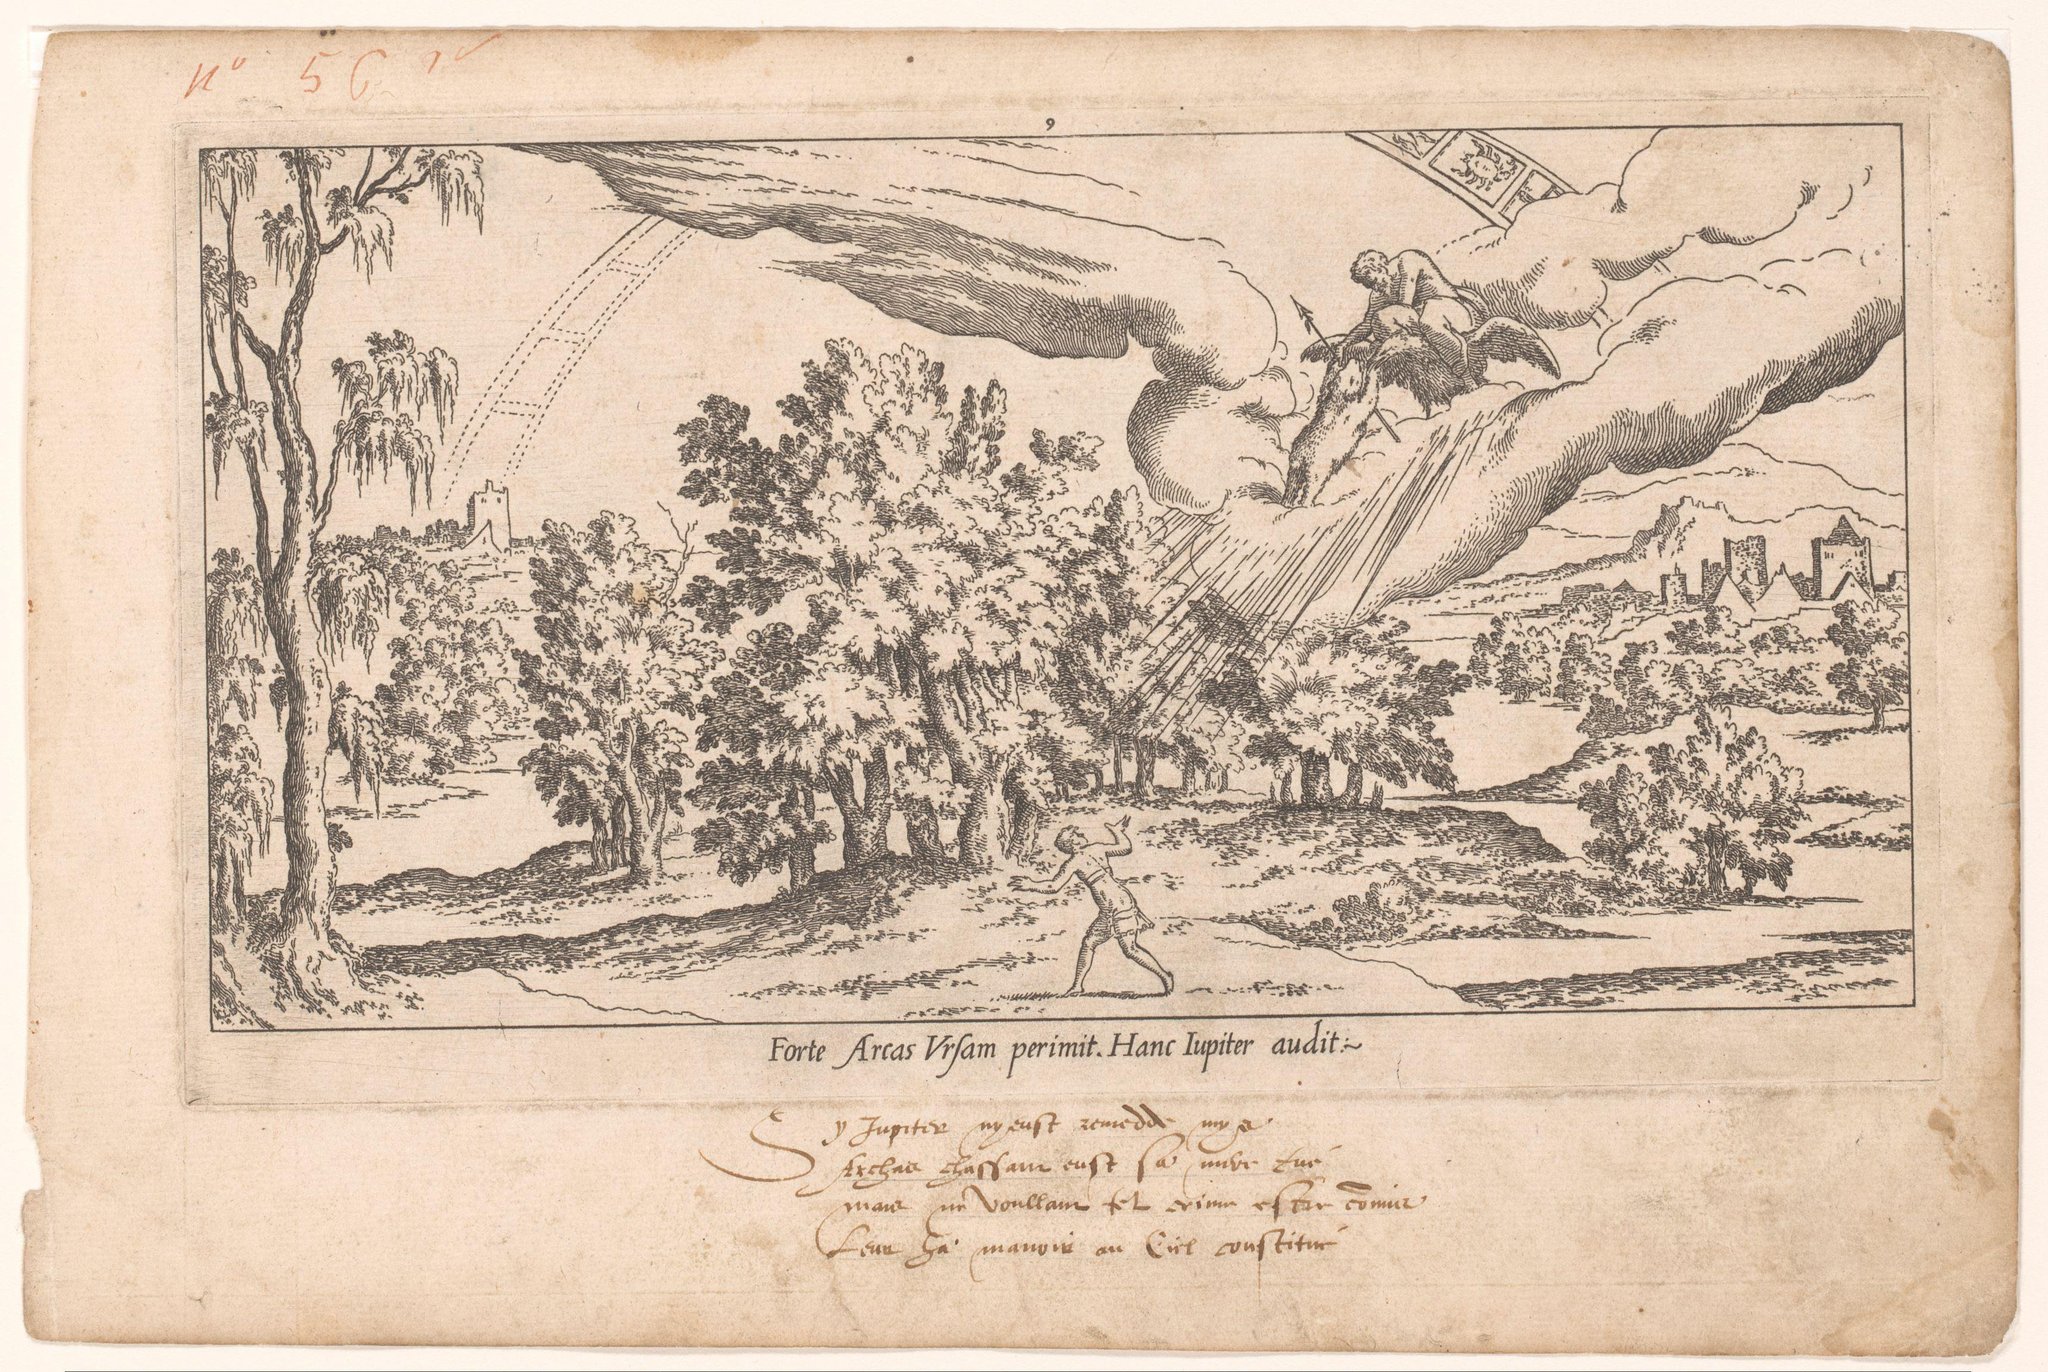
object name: print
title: Callisto wordt door Jupiter opgenomen in de sterrenhemel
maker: léon davent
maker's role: print maker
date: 1547-1550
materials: paper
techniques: etching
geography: france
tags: callisto changed into a constellation: jupiter changes callisto into a constellation, when, transformed into a bear she is about to be shot by arcas (ovid, metamorphoses ii 506)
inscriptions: collector's mark: Lugt 2760, inscription:, number:, collector's mark: Lugt 2228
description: Bosrijk landschap waarbij Callisto net niet gedood wordt door haar zoon Arcas door tussenkomst van Jupiter, die haar opneemt onder de sterrenbeelden.